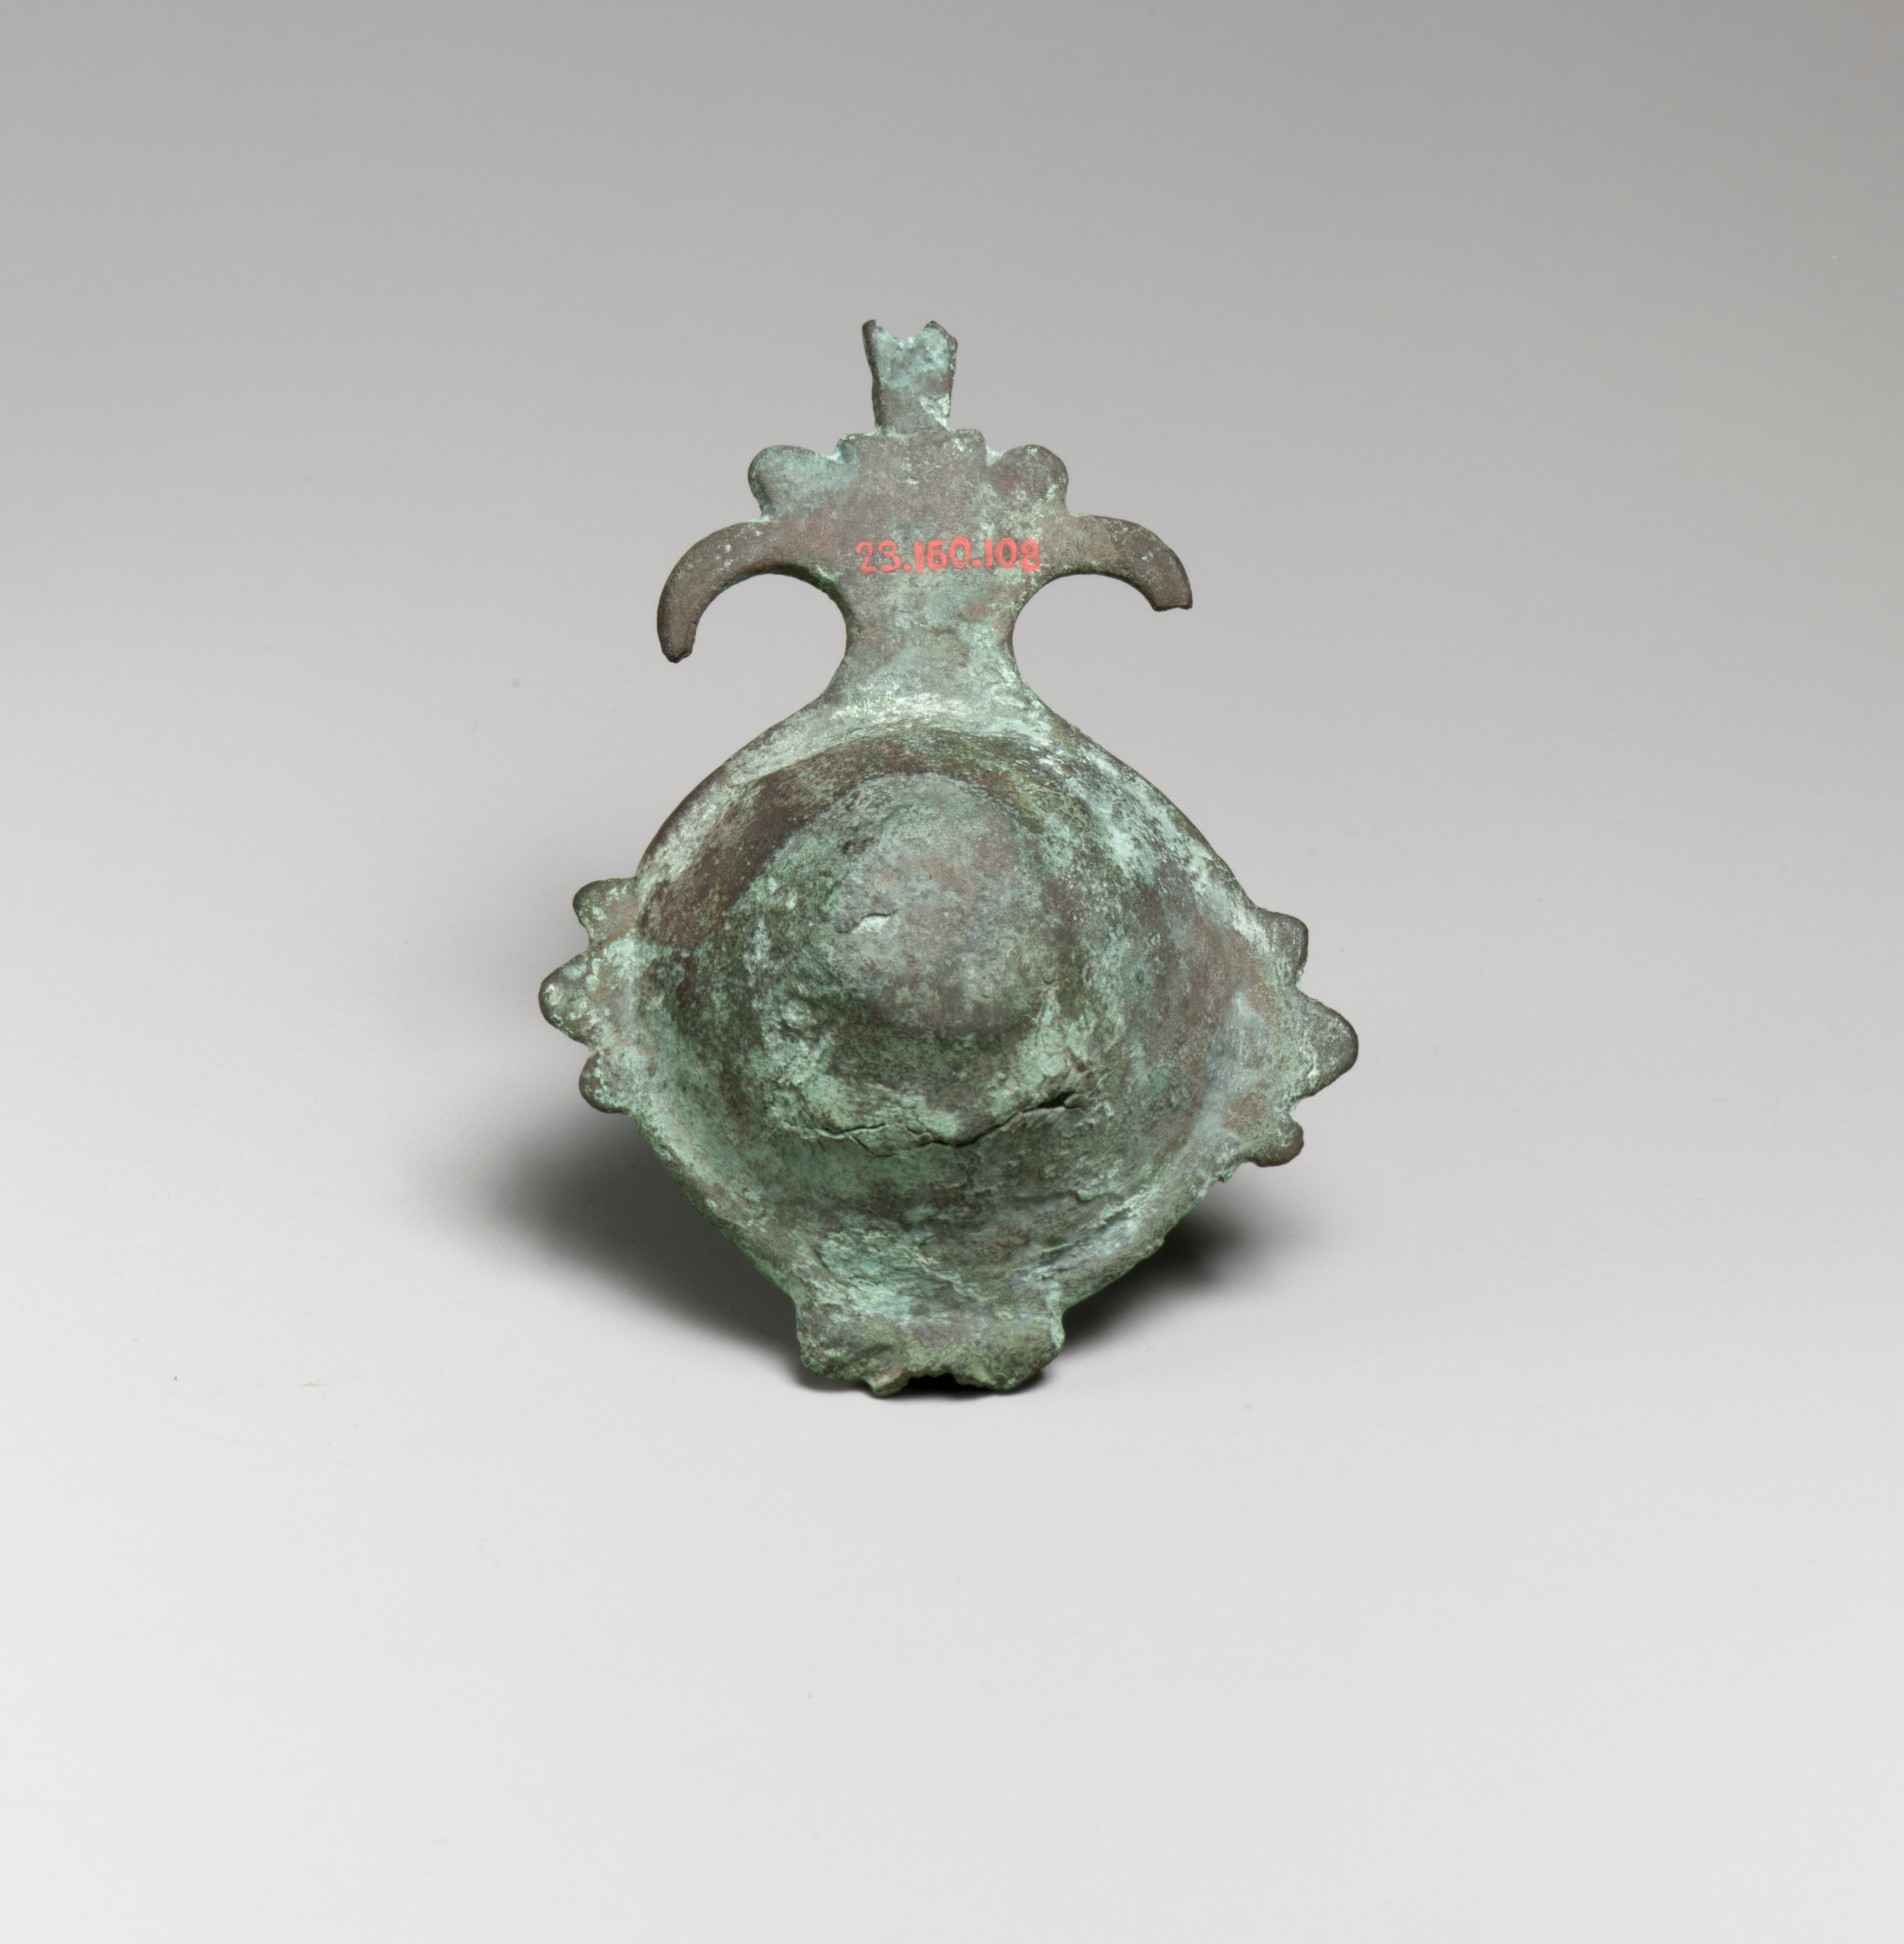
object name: lamp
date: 7000 BCE-330 CE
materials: bronze